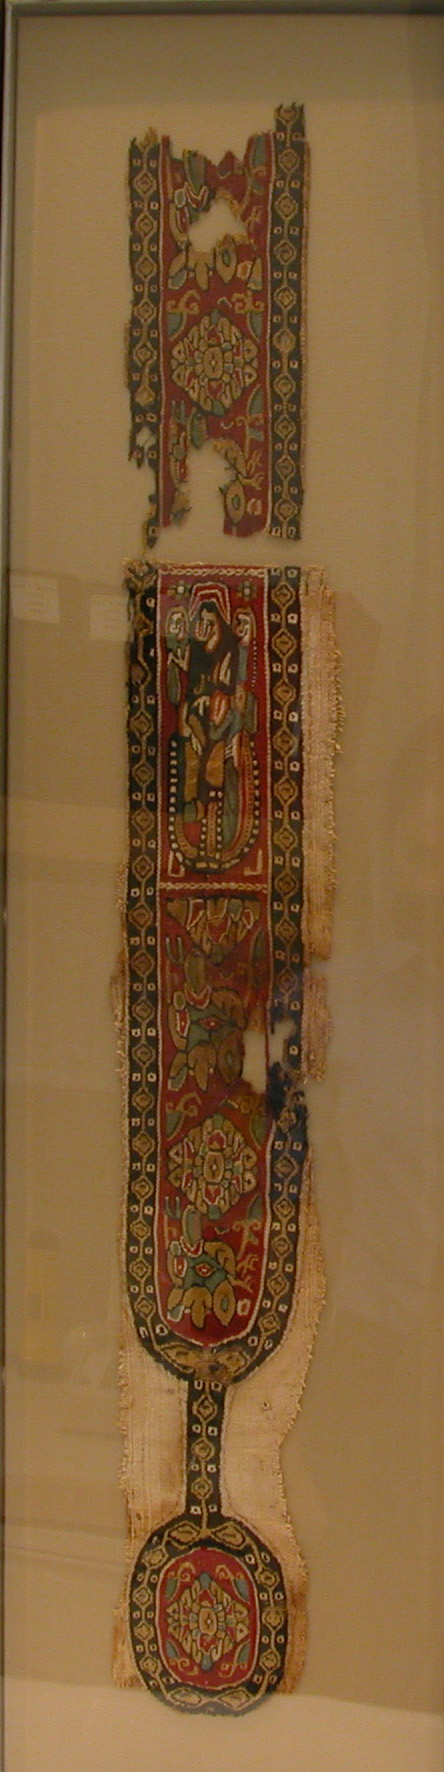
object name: textile fragment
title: Band with Figures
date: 601-1100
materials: linen, wool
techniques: weave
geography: egypt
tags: men